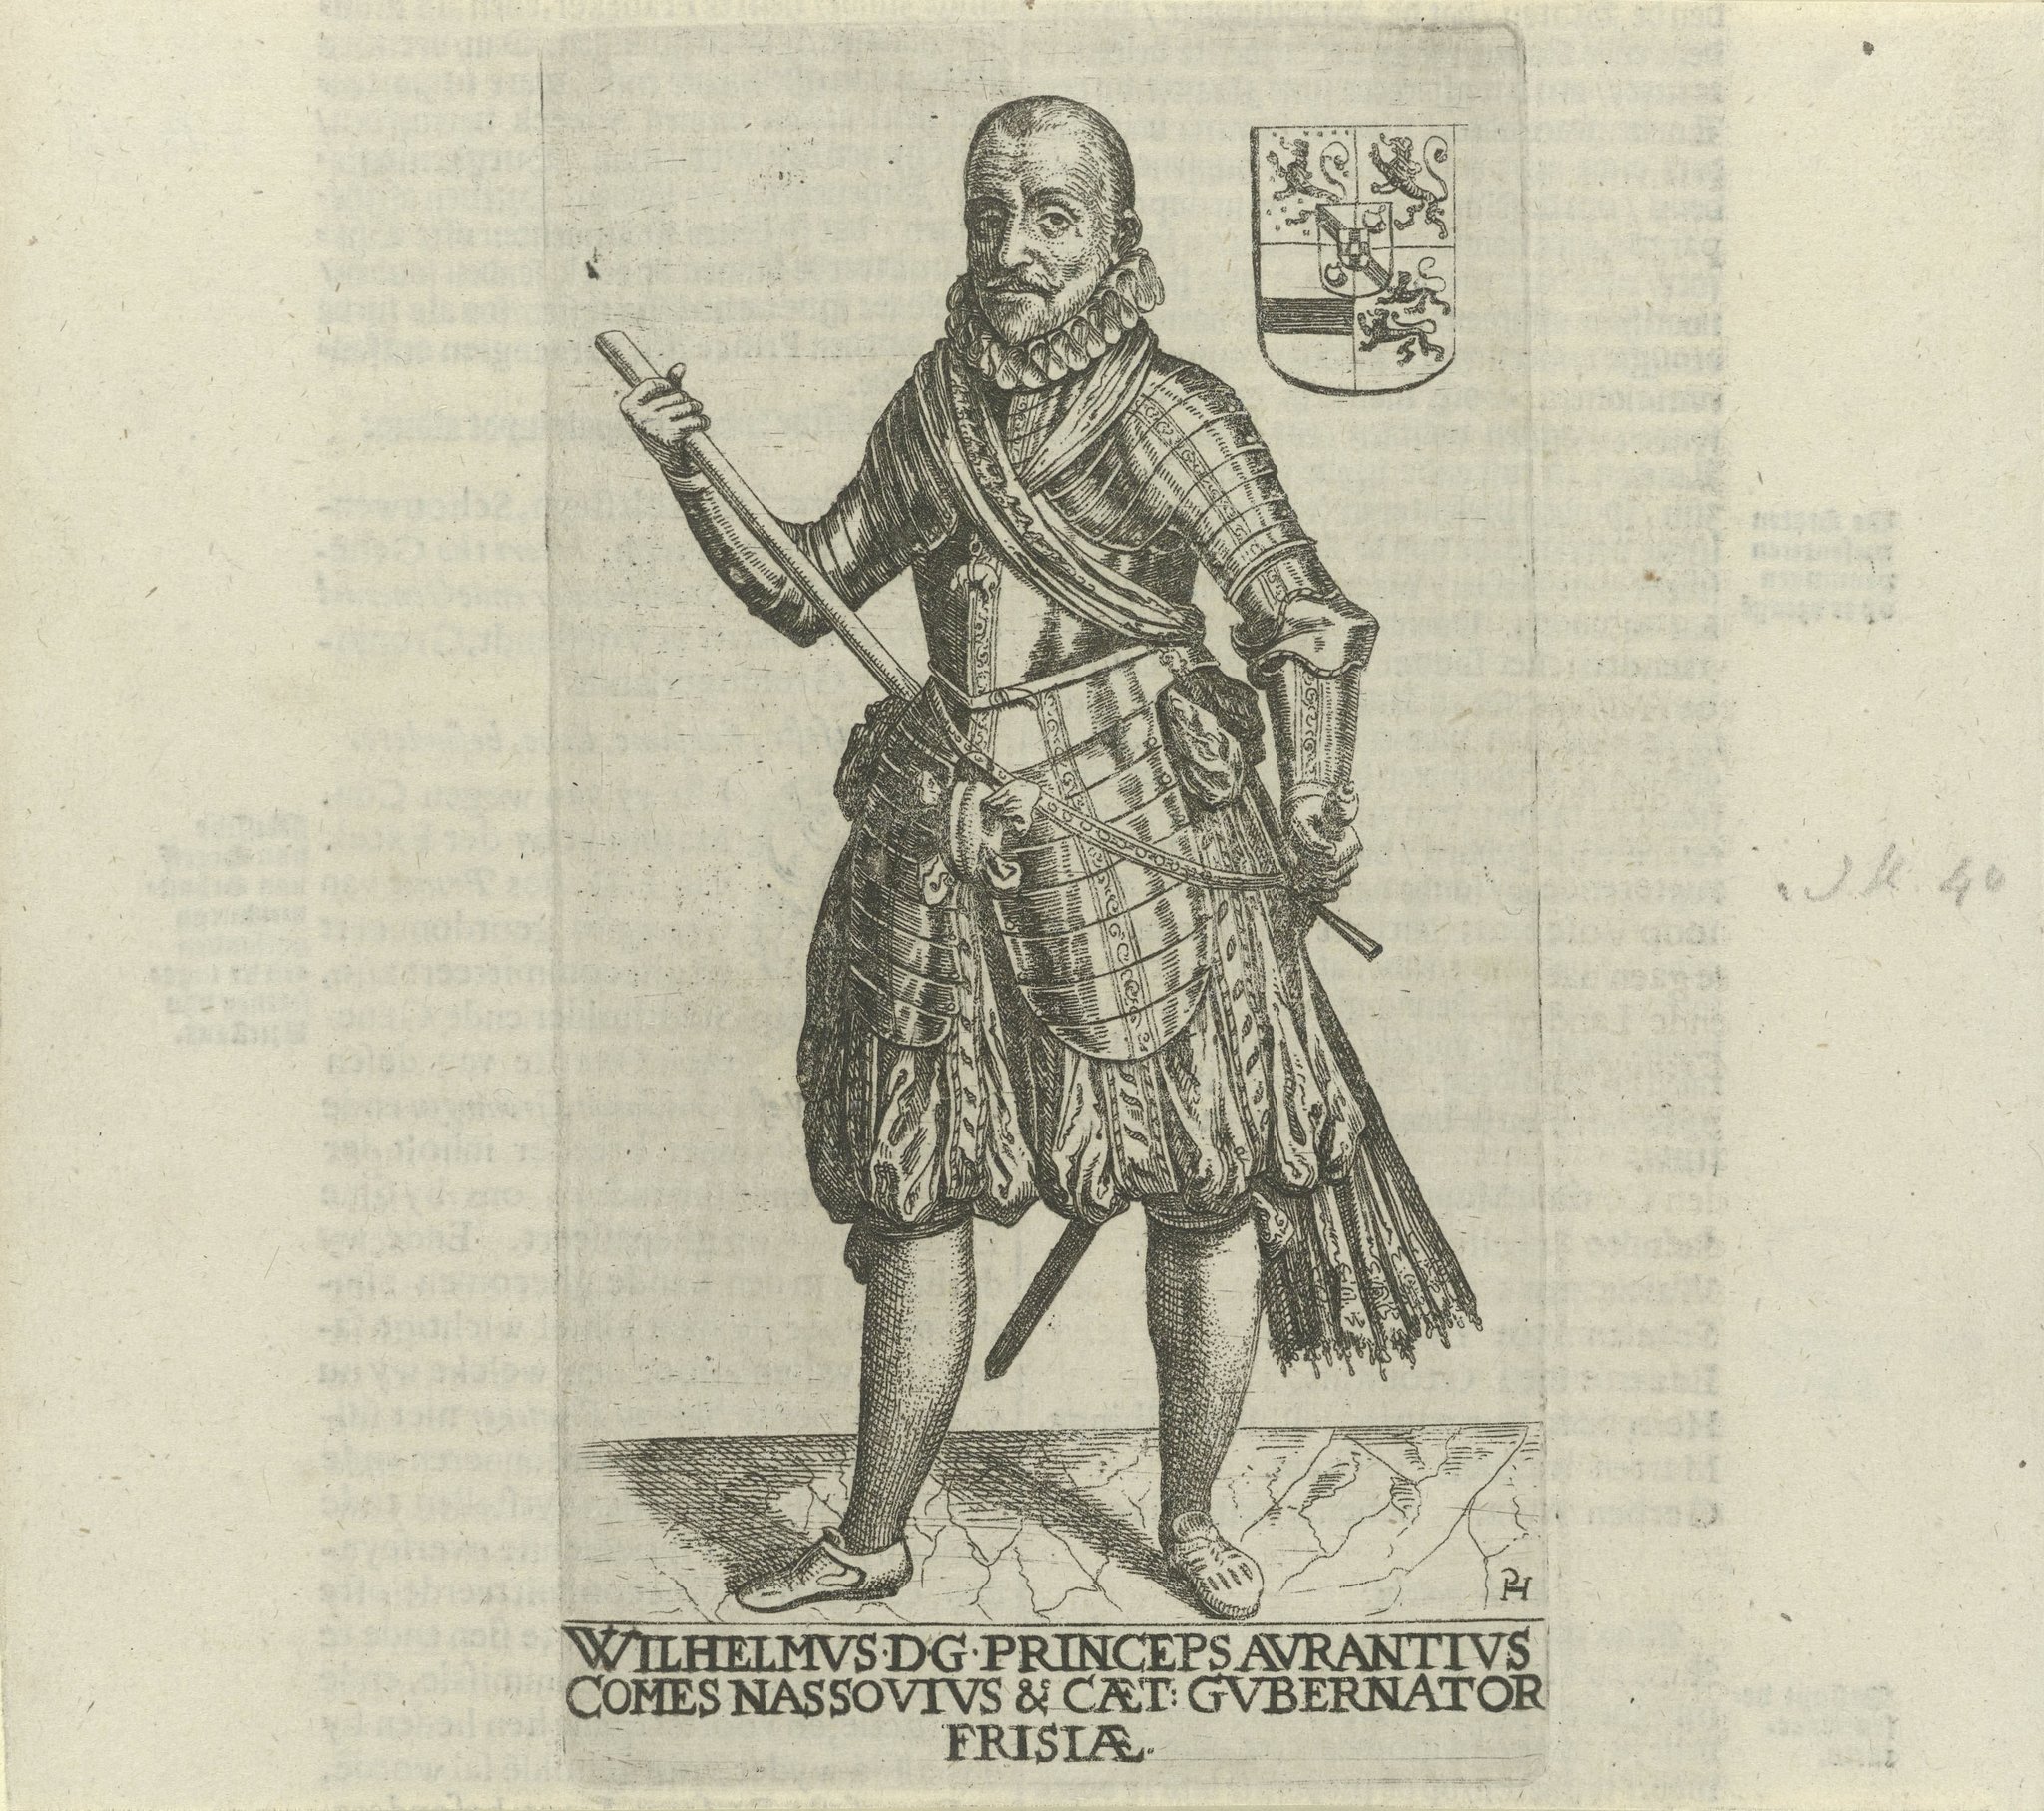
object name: book illustration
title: Portret van Willem I, prins van Oranje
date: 1622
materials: paper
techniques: engraving, etching, letterpress printing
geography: northern netherlands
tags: delft, william i (prince of orange)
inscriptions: collector's mark: Lugt 2228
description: De hier vermelde titel verwijst naar de hoogst verkregen titel van de geportretteerde, niet per se naar de titel die de geportretteerde op deze voorstelling draagt. Prent uit: Winsemius, Pierius. Chroniqve ofte historische geschiedenisse van Vrieslant. Franeker: Joannes Lamrinck, 1622.